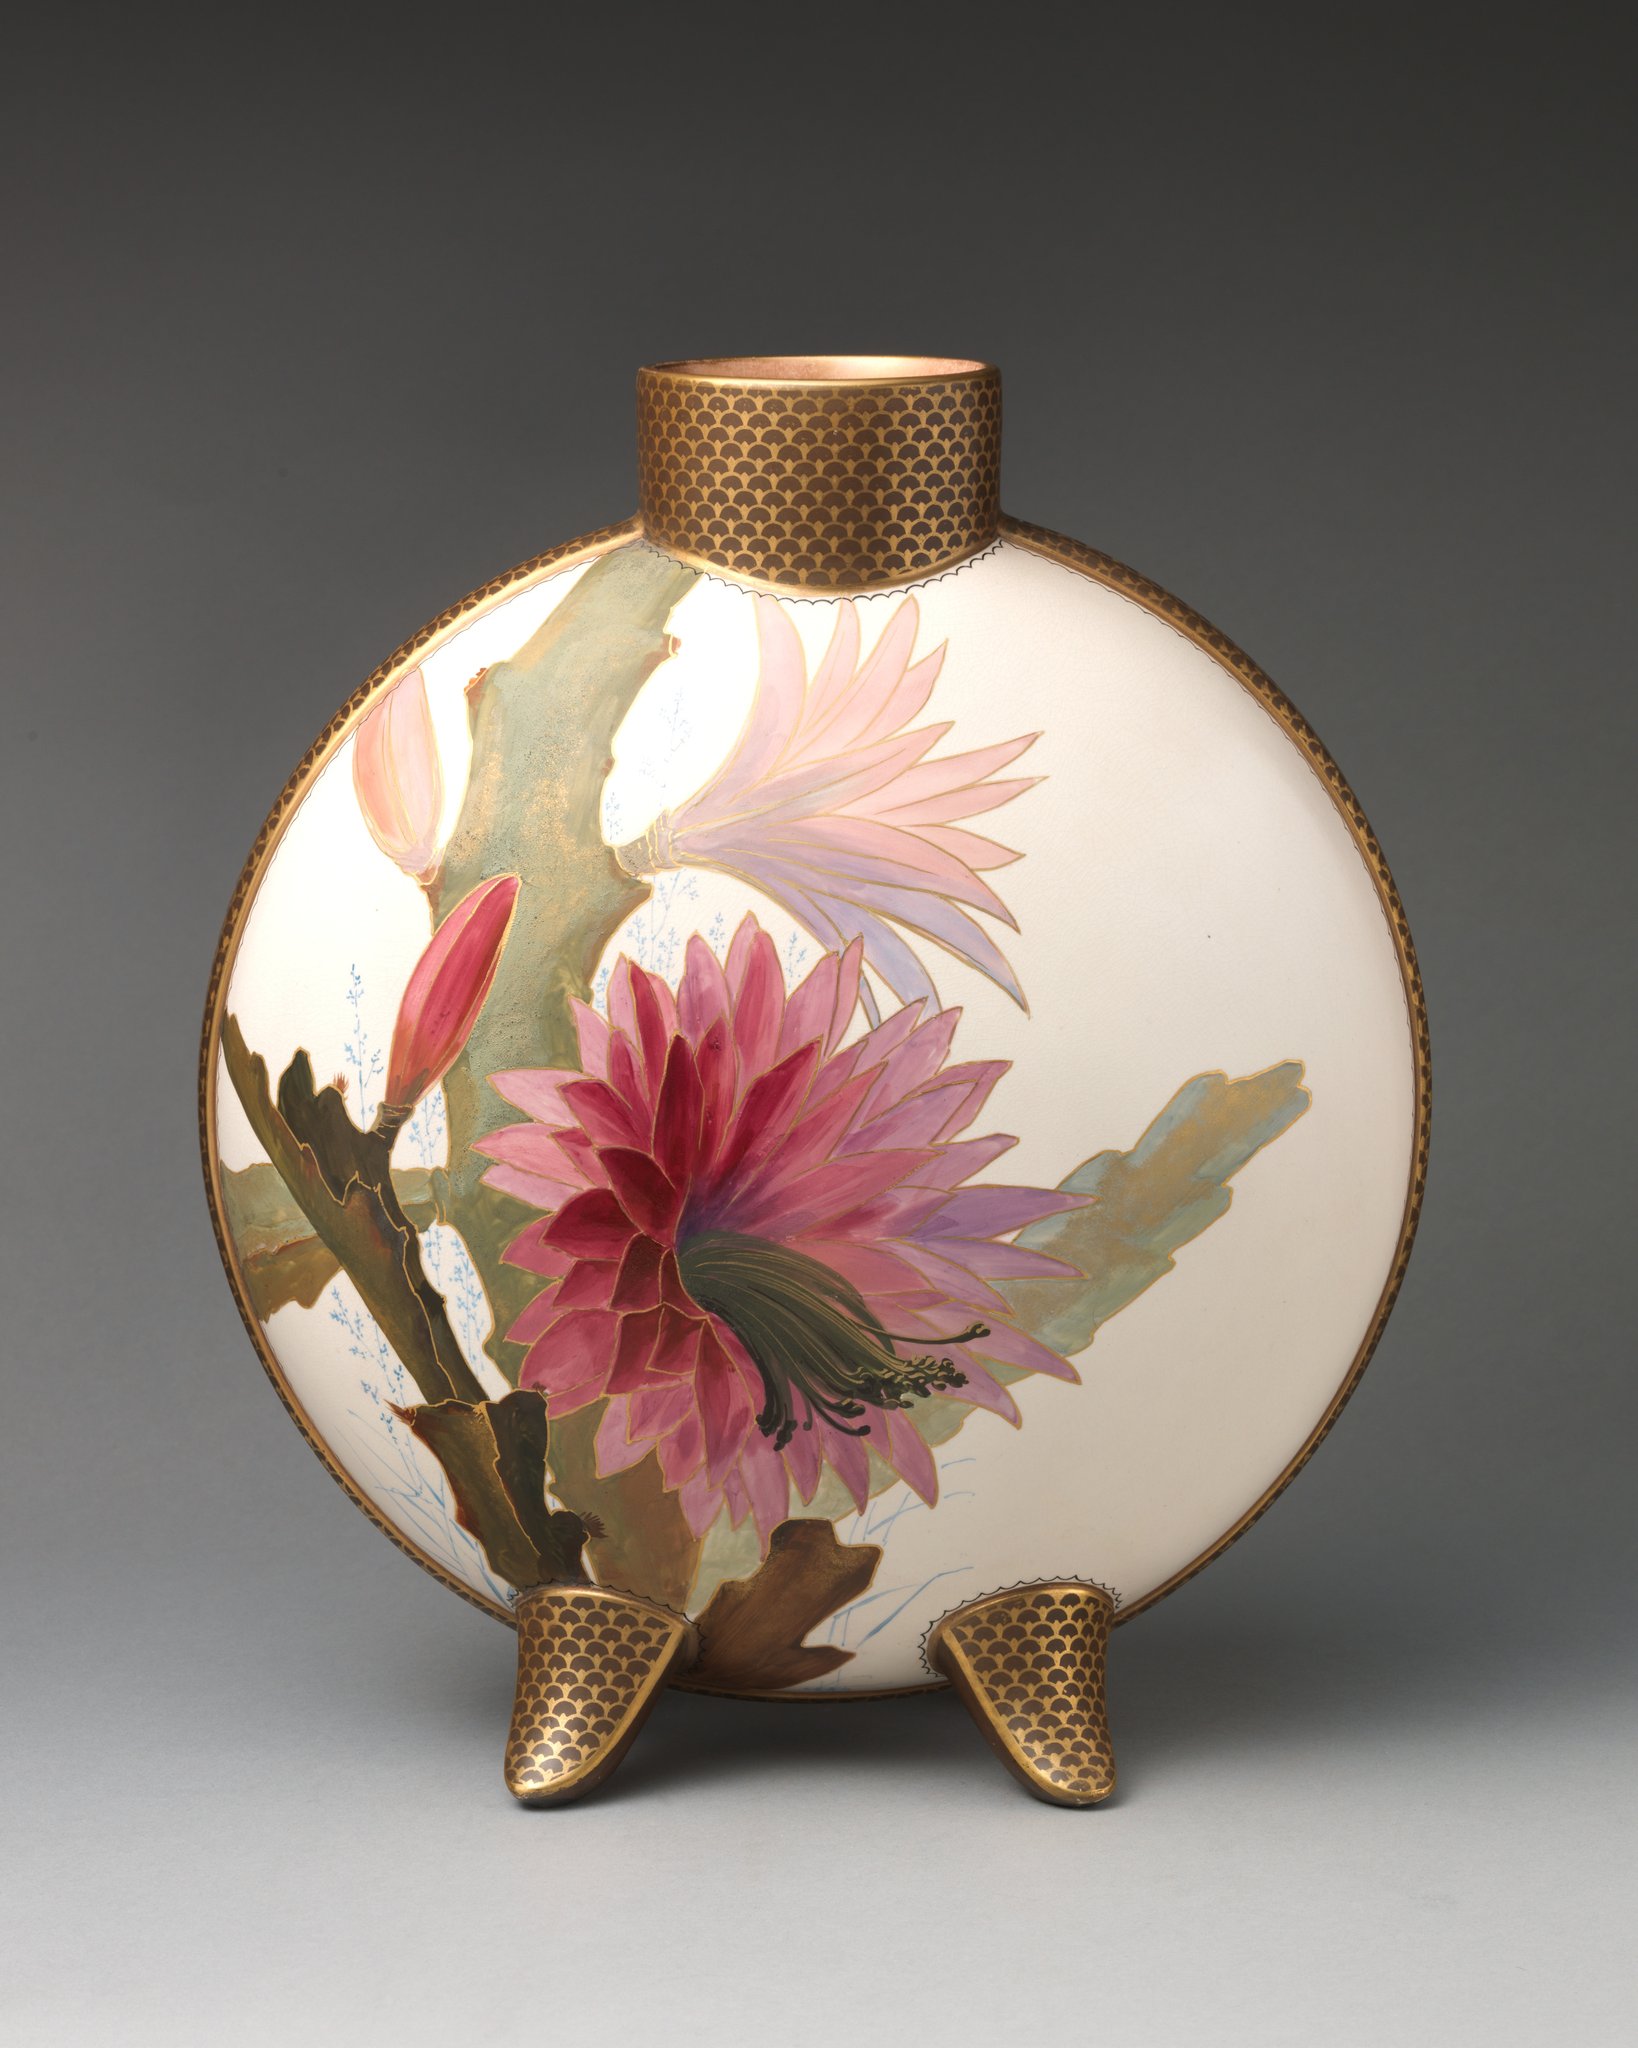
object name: moon flask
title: Moon flask with pink flower motif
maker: doulton manufactory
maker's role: maker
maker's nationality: british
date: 1882-1891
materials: earthenware, enamel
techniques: gilding